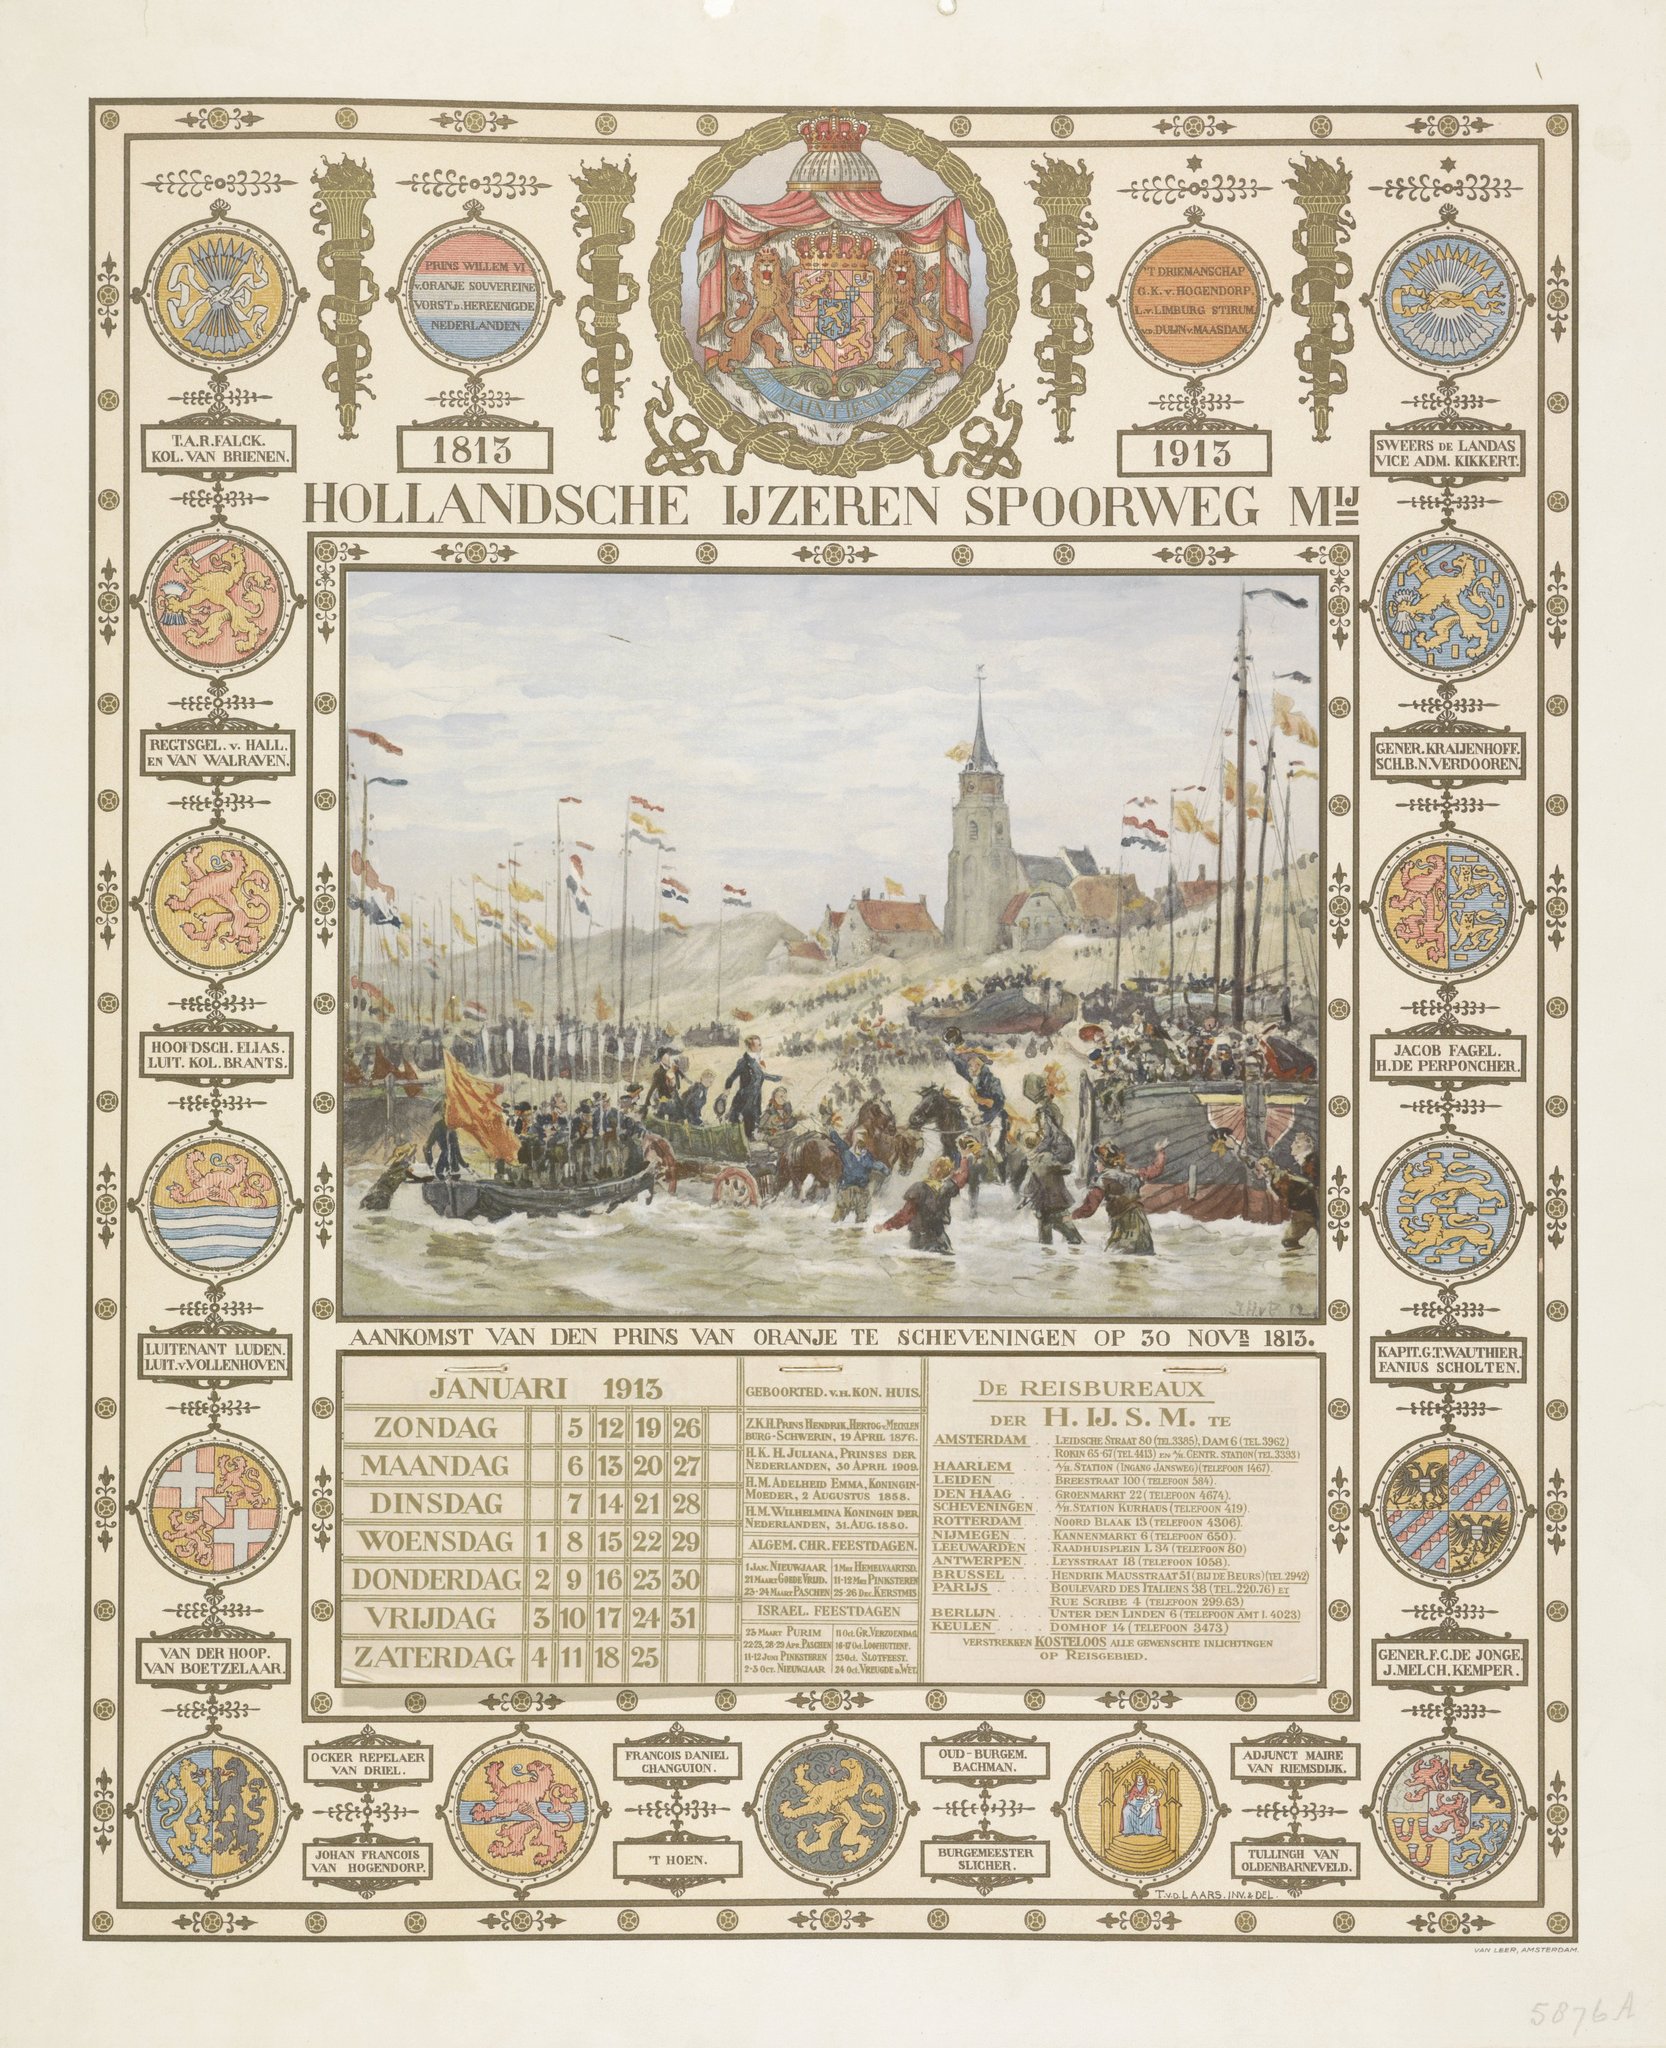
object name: book illustration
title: Portret van Friedrich Ernst Daniel Schleiermacher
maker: friedrich leonhard lehmann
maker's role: print maker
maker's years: 1787-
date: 1840-1855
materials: paper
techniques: engraving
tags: berlin, historical persons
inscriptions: collector's mark: Lugt 2228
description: Prent afkomstig uit: Conversations-Lexikon für die gebildeten Stände, voor het eerst uitgegeven tussen 1840-1855.